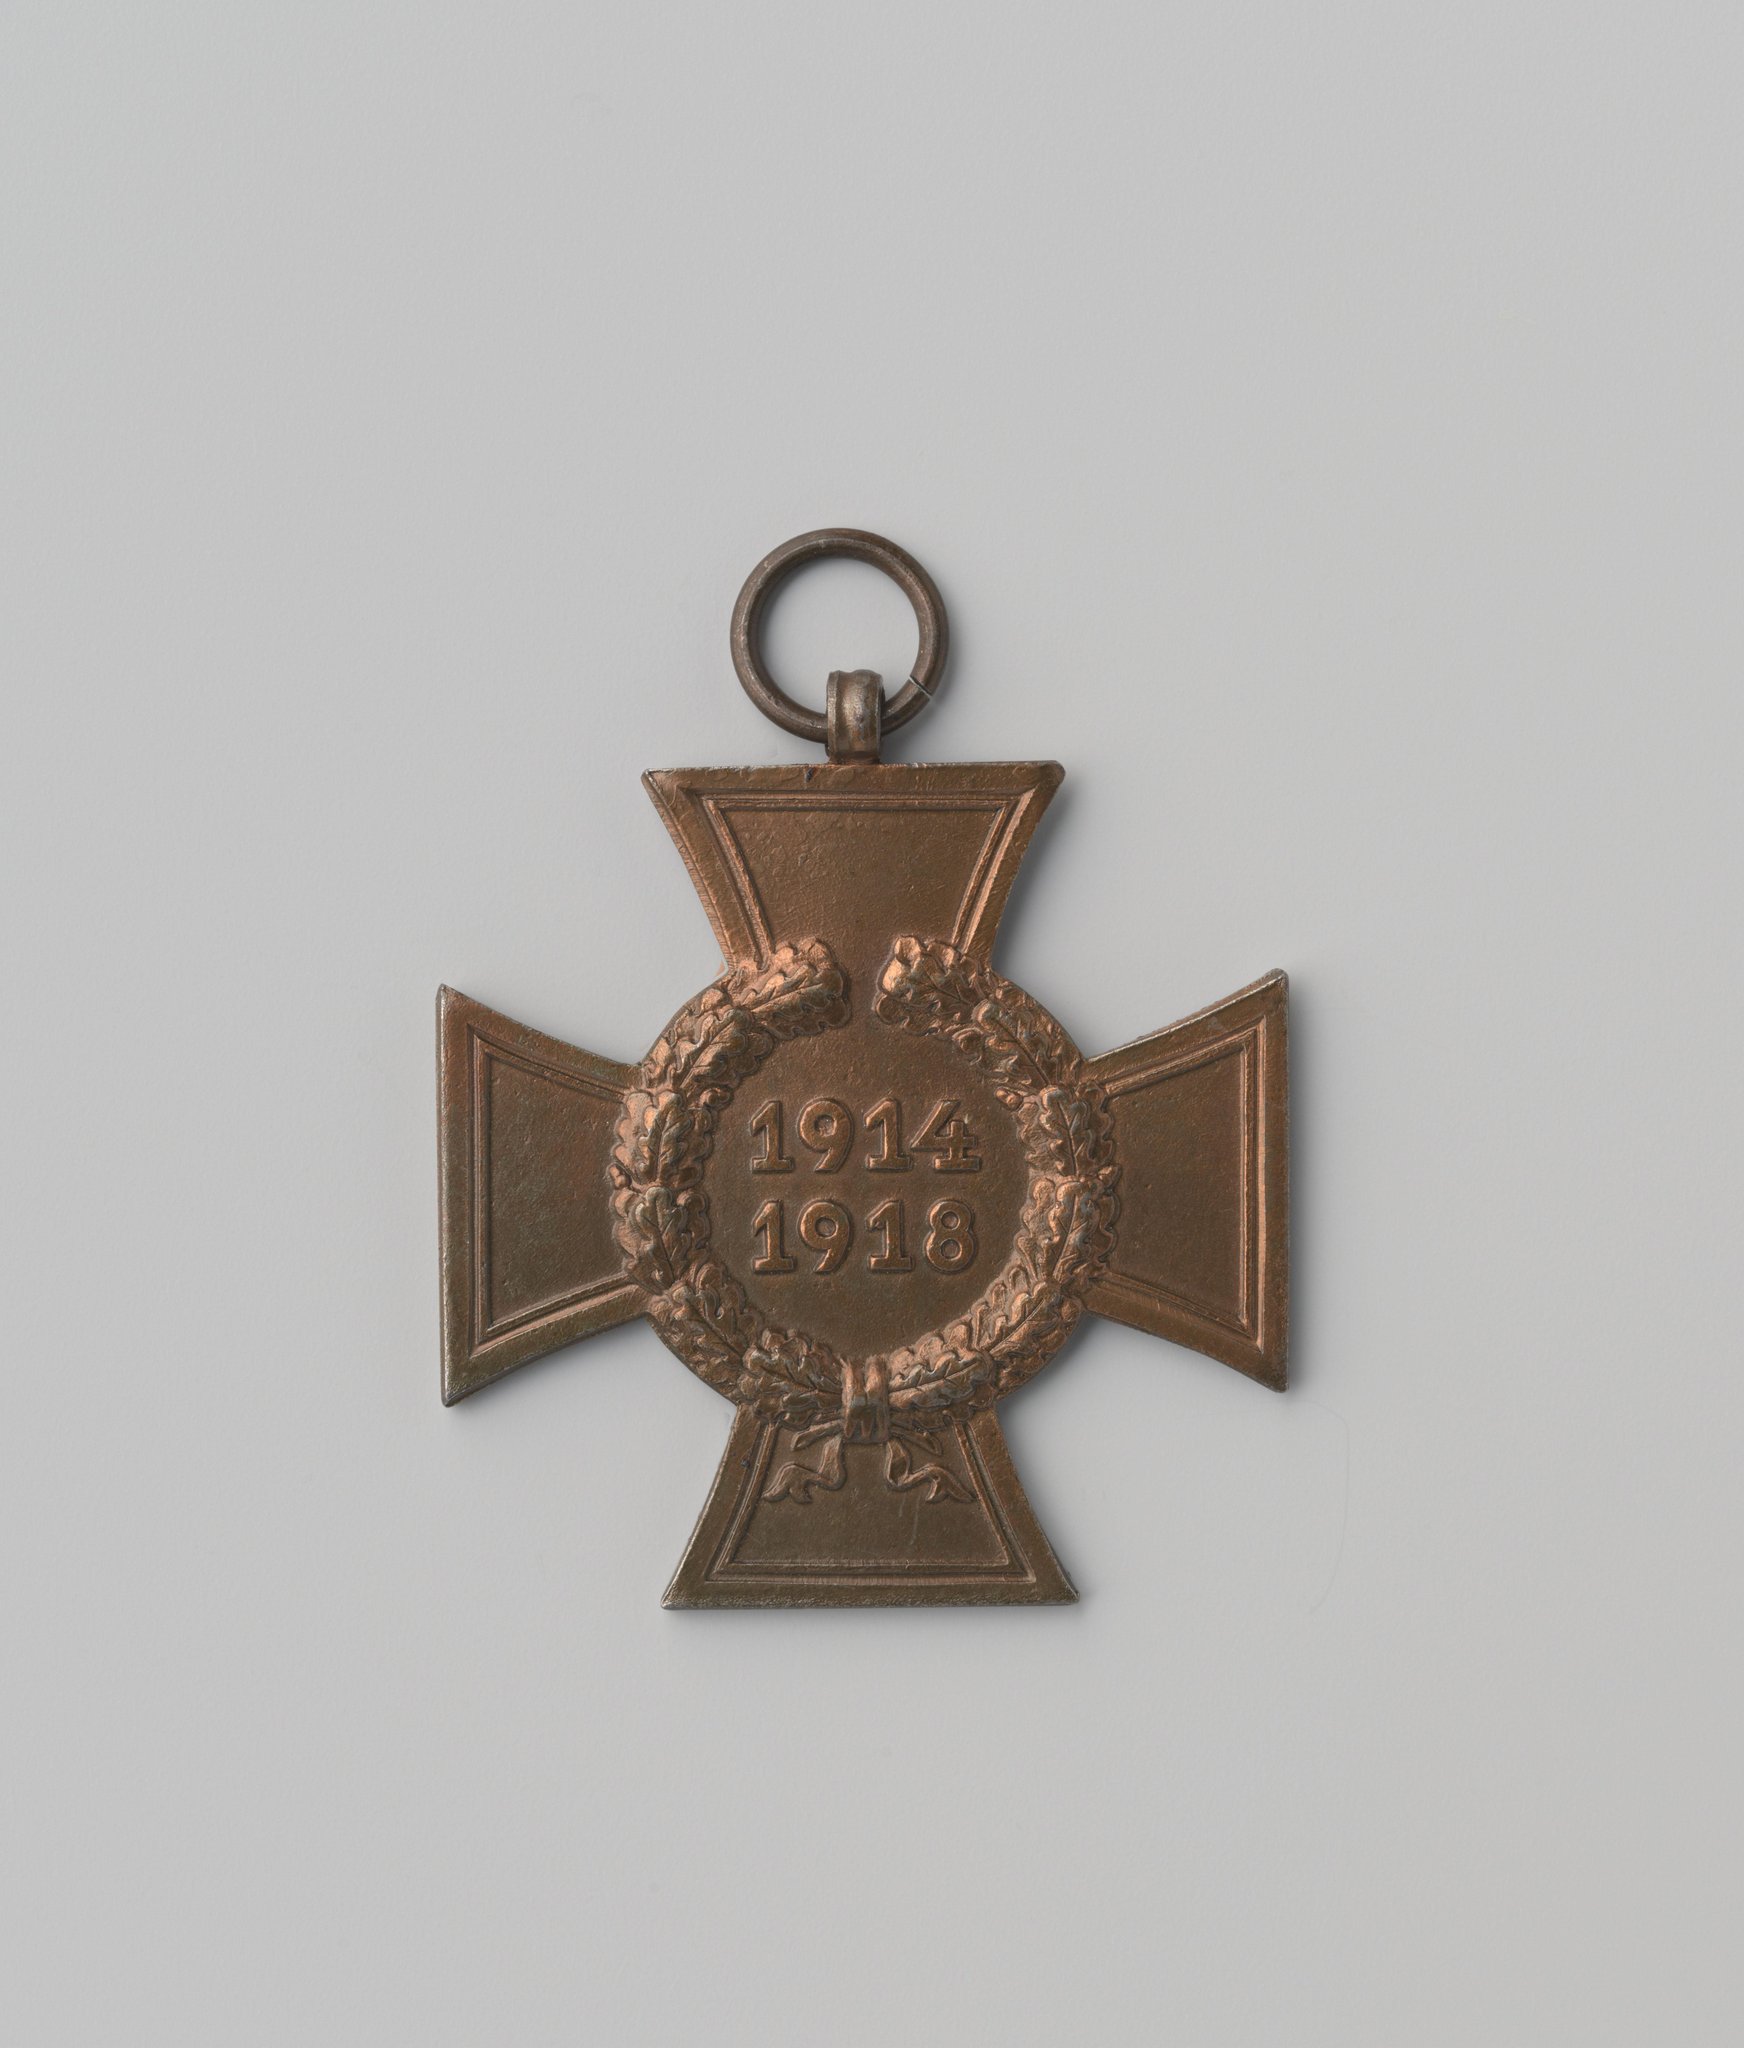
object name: onderscheidingsteken, onderscheiding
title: Erekruis van de Wereldoorlog (Duitsland)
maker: Anonymous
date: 1935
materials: metal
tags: eugen wachenheimer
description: Dit object is onderdeel van de nalatenschap van Isabel Elon-Wachenheimer (1928-2010). Tot haar overlijden behoorde het samen met de andere objecten uit de nalatenschap tot haar privédomein van Isabel Wachenheimer. In die particuliere context zijn deze objecten tezamen en individueel aandenkens - aan de jeugd, ouders en familie van Isabel Wachenheimer vóór en tijdens de Shoah en aan haar leven na de Tweede Wereldoorlog. Isabel Wachenheimer, die van juni 1943 tot mei 1945 gevangen zat in Kamp Westerbork, Theresienstadt, Auschwitz, Lenzing a/d Oberdonau (een buitenkamp van Mauthausen), overleefde de Shoah. Haar ouders – Eugène Wachenheimer en Else Wachenheimer-Moos - werden op 14 oktober 1944 in Auschwitz-Birkenau vermoord.